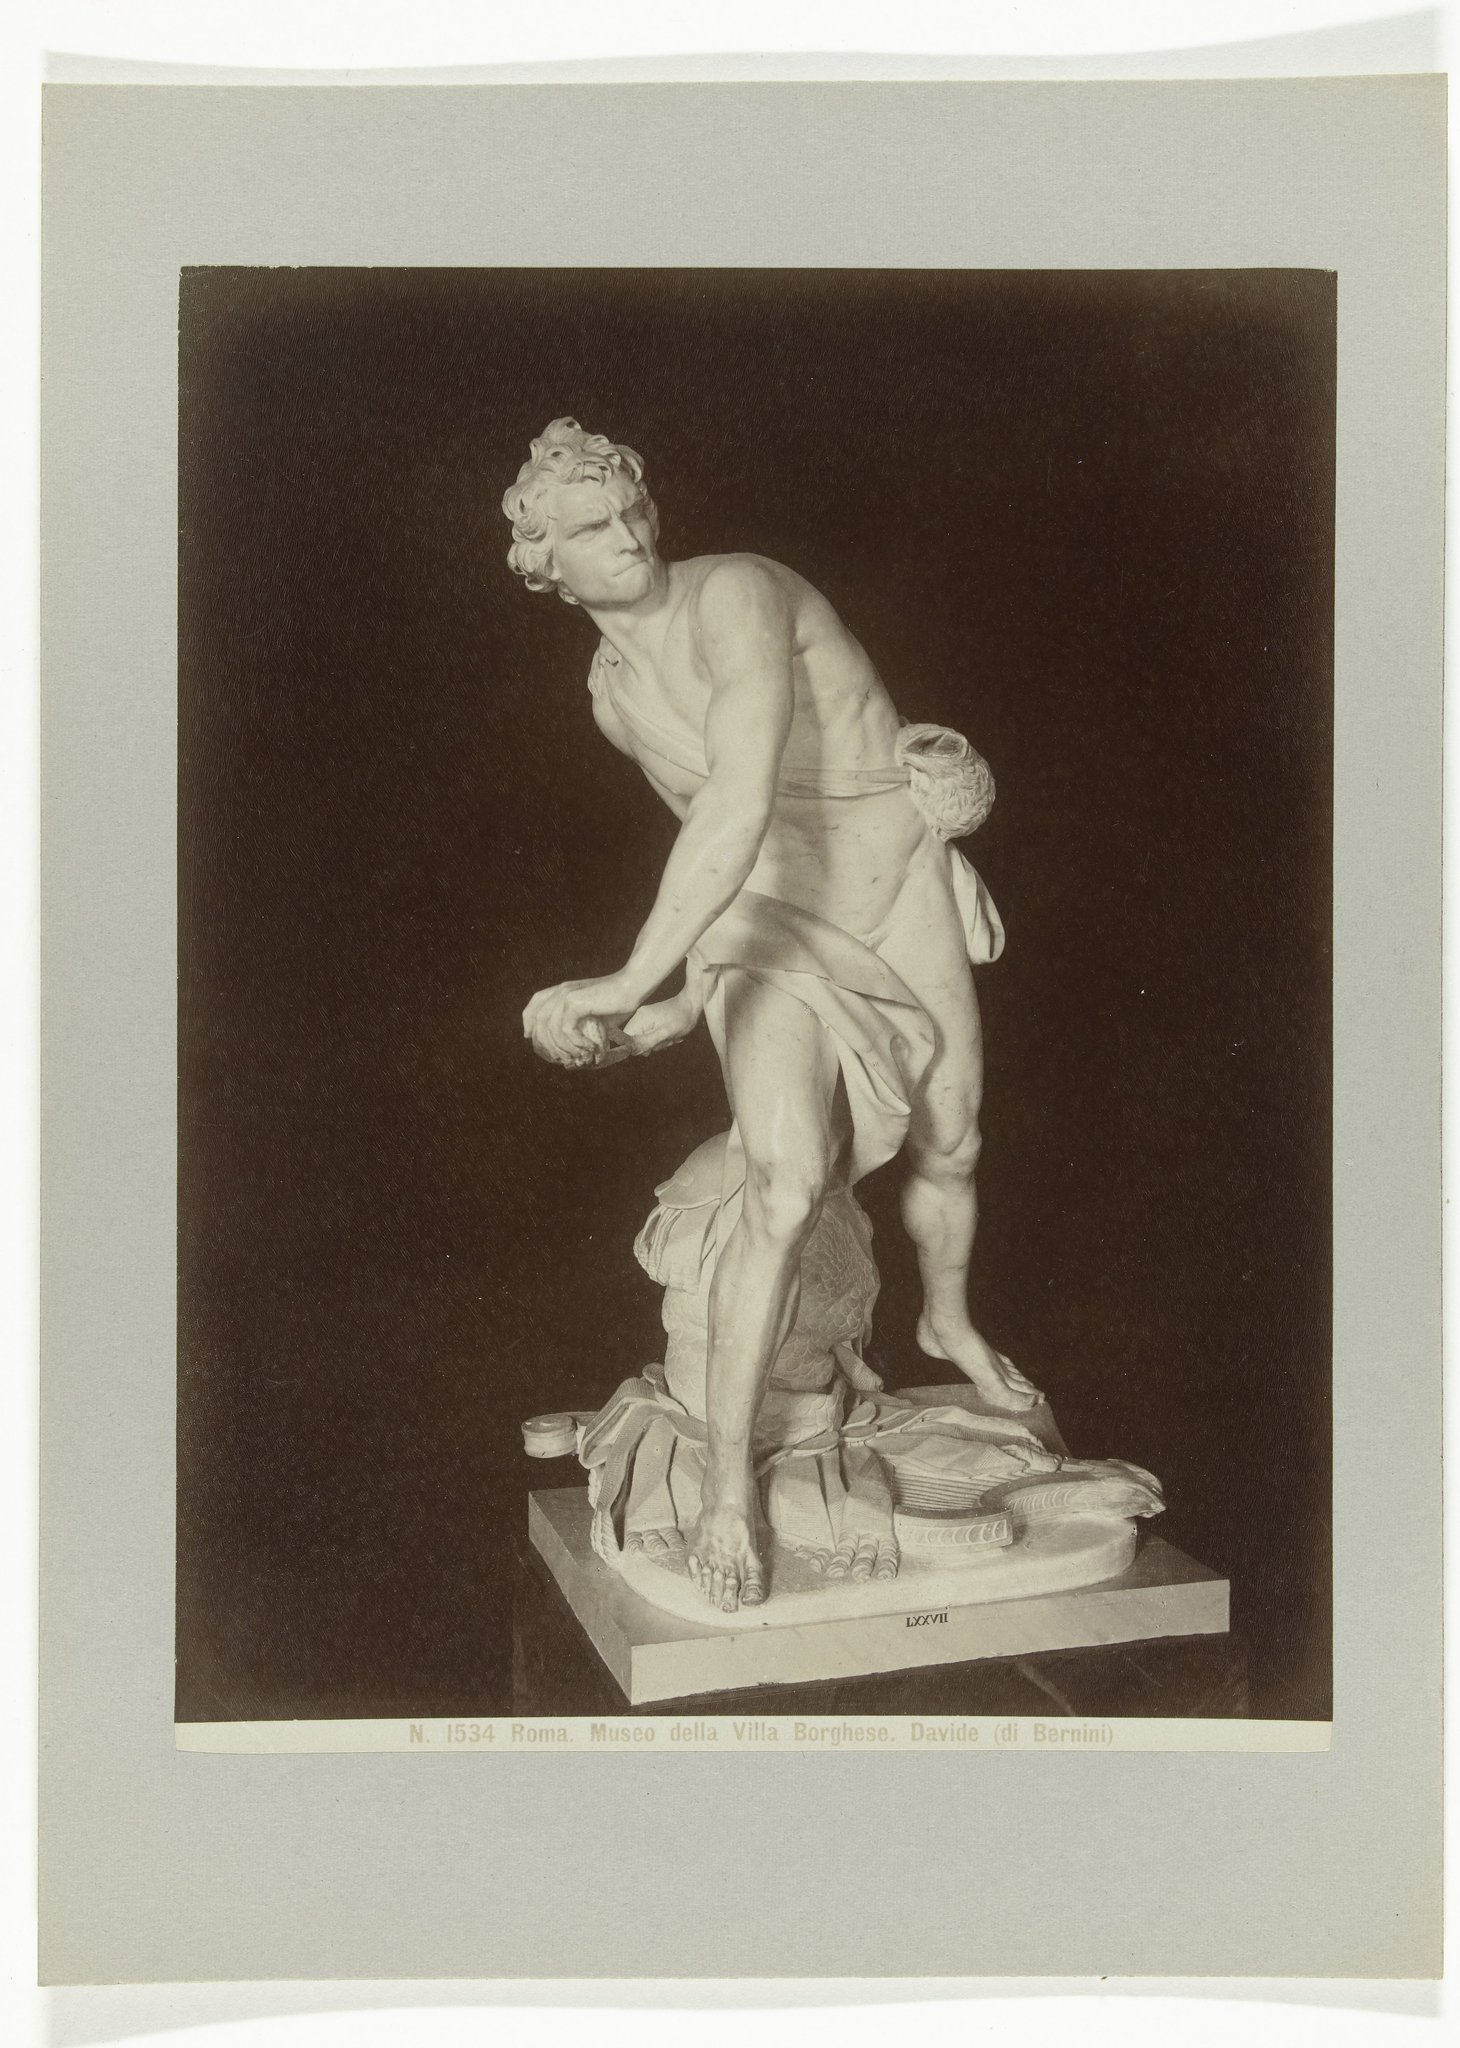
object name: photograph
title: Sculptuur van David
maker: Anonymous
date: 1880-1904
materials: cardboard, paper, photographic support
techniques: albumen print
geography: rome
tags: rome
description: Sculptuur van David die op het punt staat een steen te gooien naar Goliath, gemaakt door Bernini.